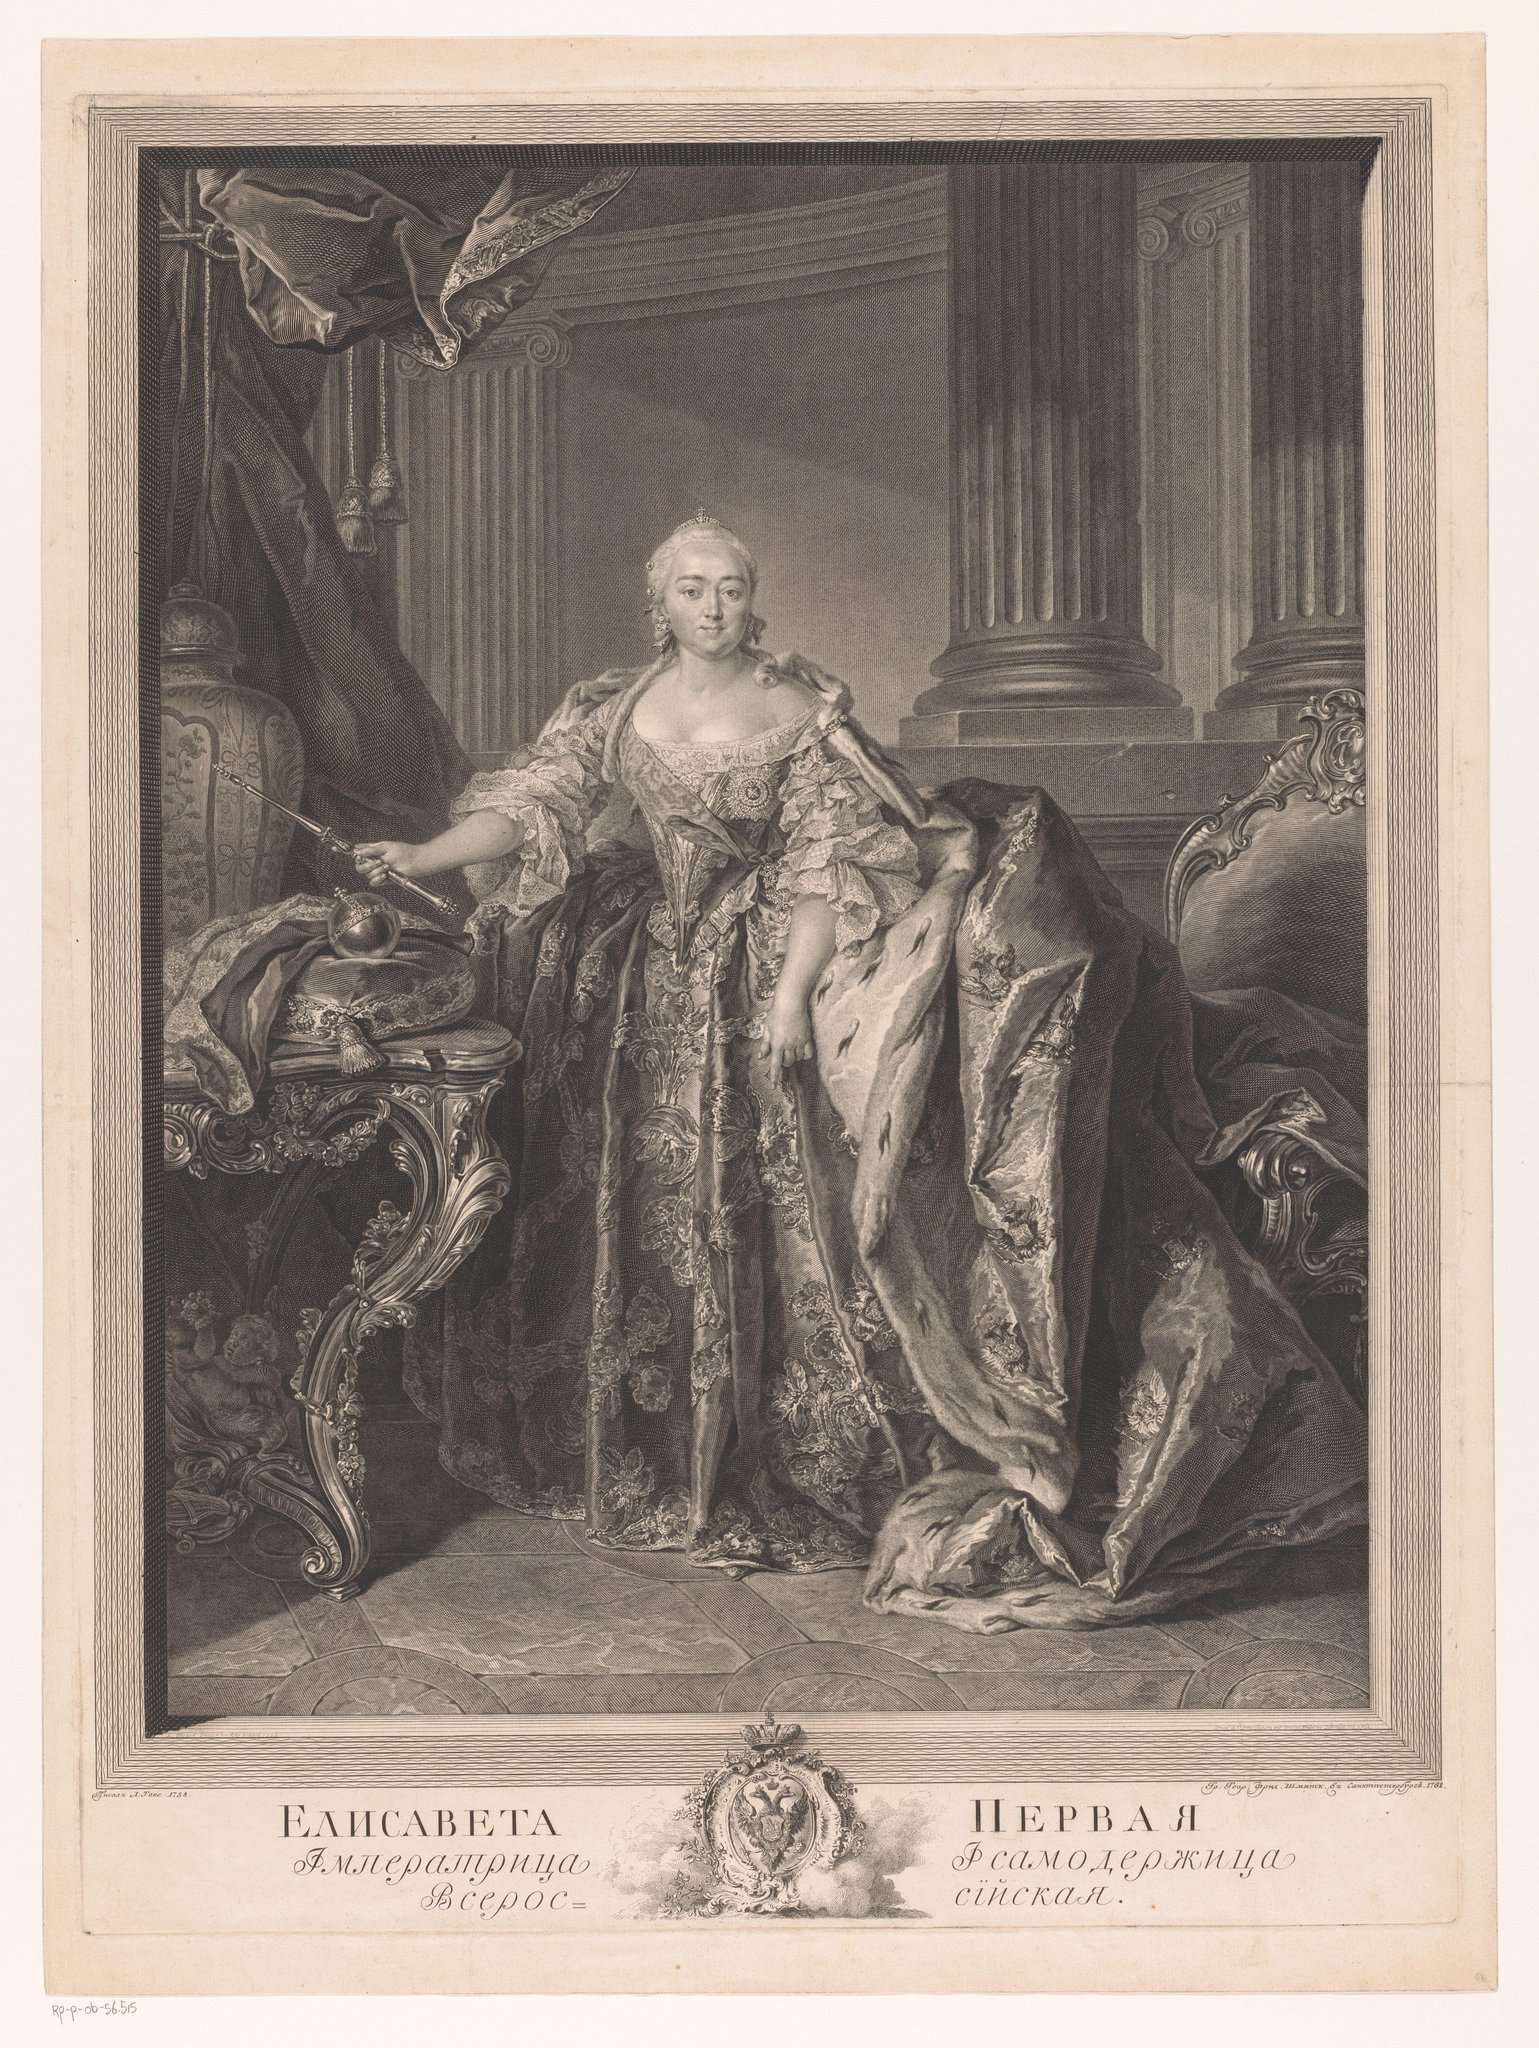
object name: print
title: Portret van Elisabeth Petrovna, tsarina van Rusland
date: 1761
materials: paper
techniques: engraving, etching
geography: sint-petersburg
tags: emperor - bb - female ruler, armorial bearing, heraldry, insignia and symbols of sovereignty (crown, diadem, sceptre, orb, seal, standard, cloak, pectoral)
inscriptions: collector's mark: Lugt 240